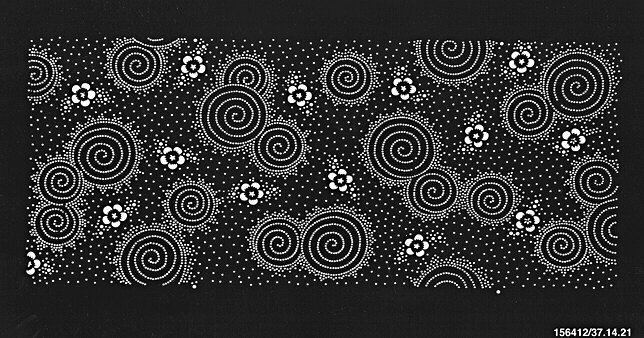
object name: stencil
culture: japanese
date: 1801-1833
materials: paper